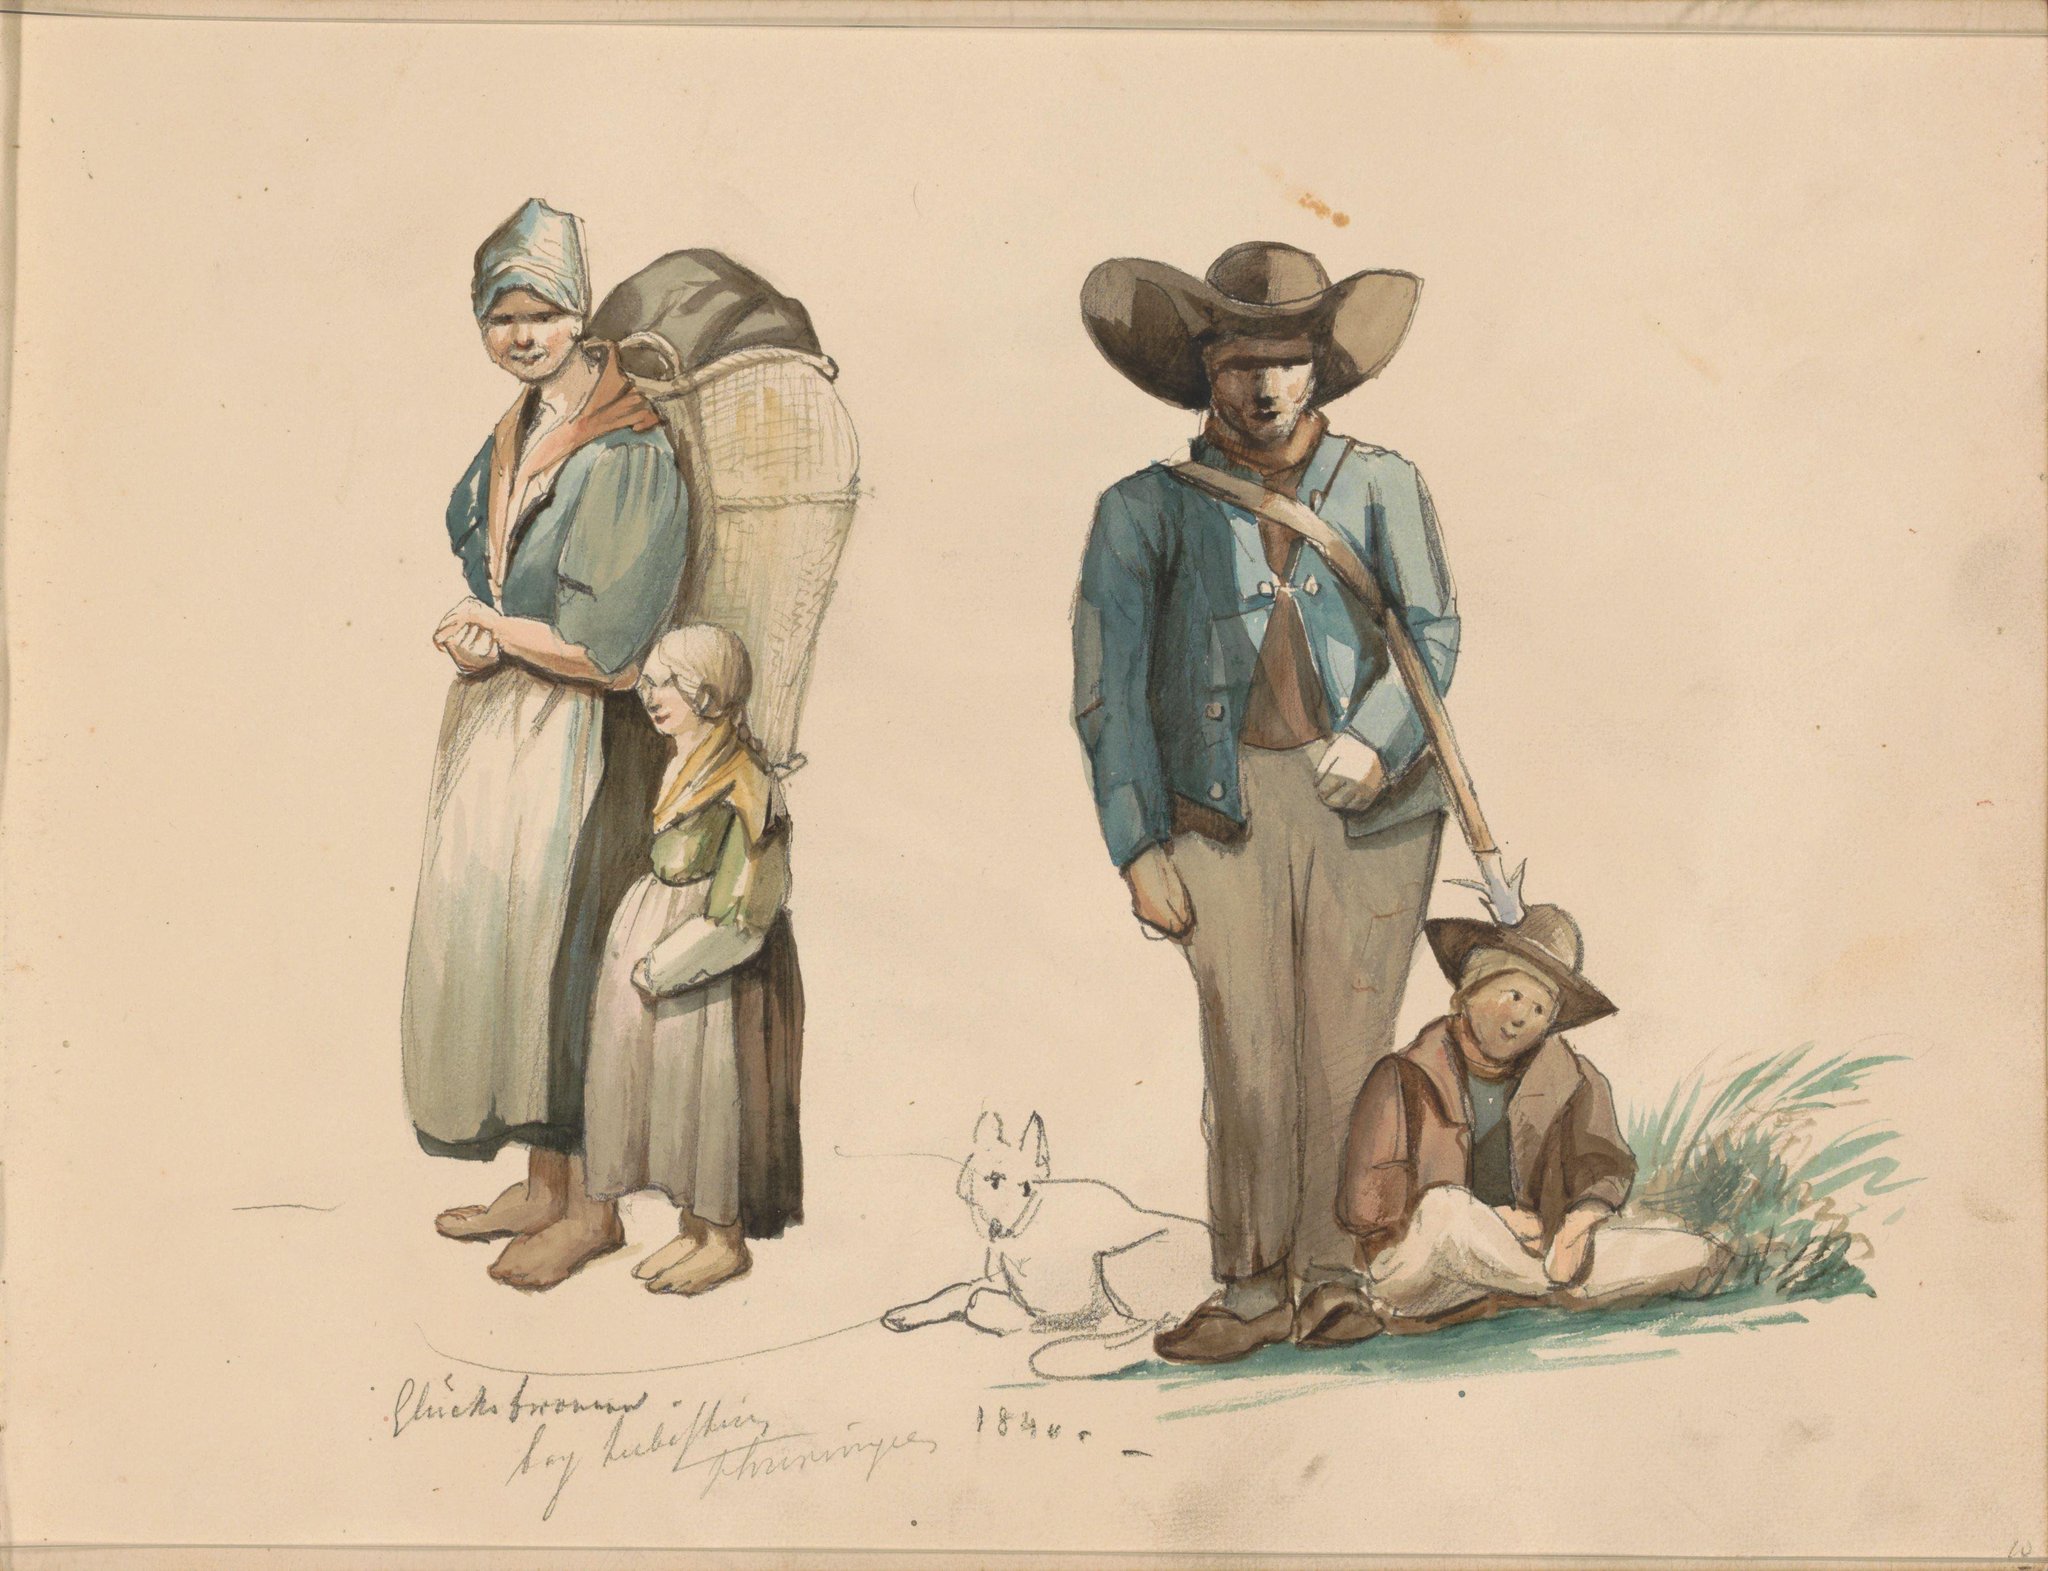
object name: sketchbook leaf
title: Geluksbeelden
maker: johannes tavenraat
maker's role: draughtsman, painter, print maker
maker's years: 1809-1881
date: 1840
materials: paper, pencil, watercolor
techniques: brush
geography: liebenstein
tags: magic objects and 'apotropaia', sculpture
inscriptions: date and inscription: ‘Glücksbronnen?/ bij Liebestein/ Thuringen/ 1840’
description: De gelukspoppen zijn in de vorm van figuren, namelijk een vrouw met een mand en kind en een man met zittend kind. Blad 10 recto uit een schetsboek met 43 bladen.